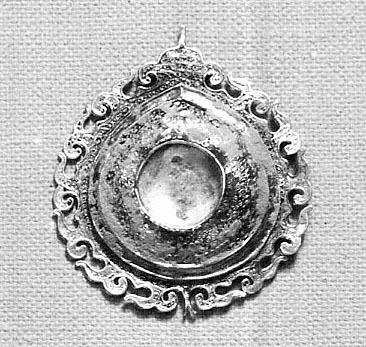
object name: brooch or pendant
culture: chinese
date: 960-1279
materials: gold